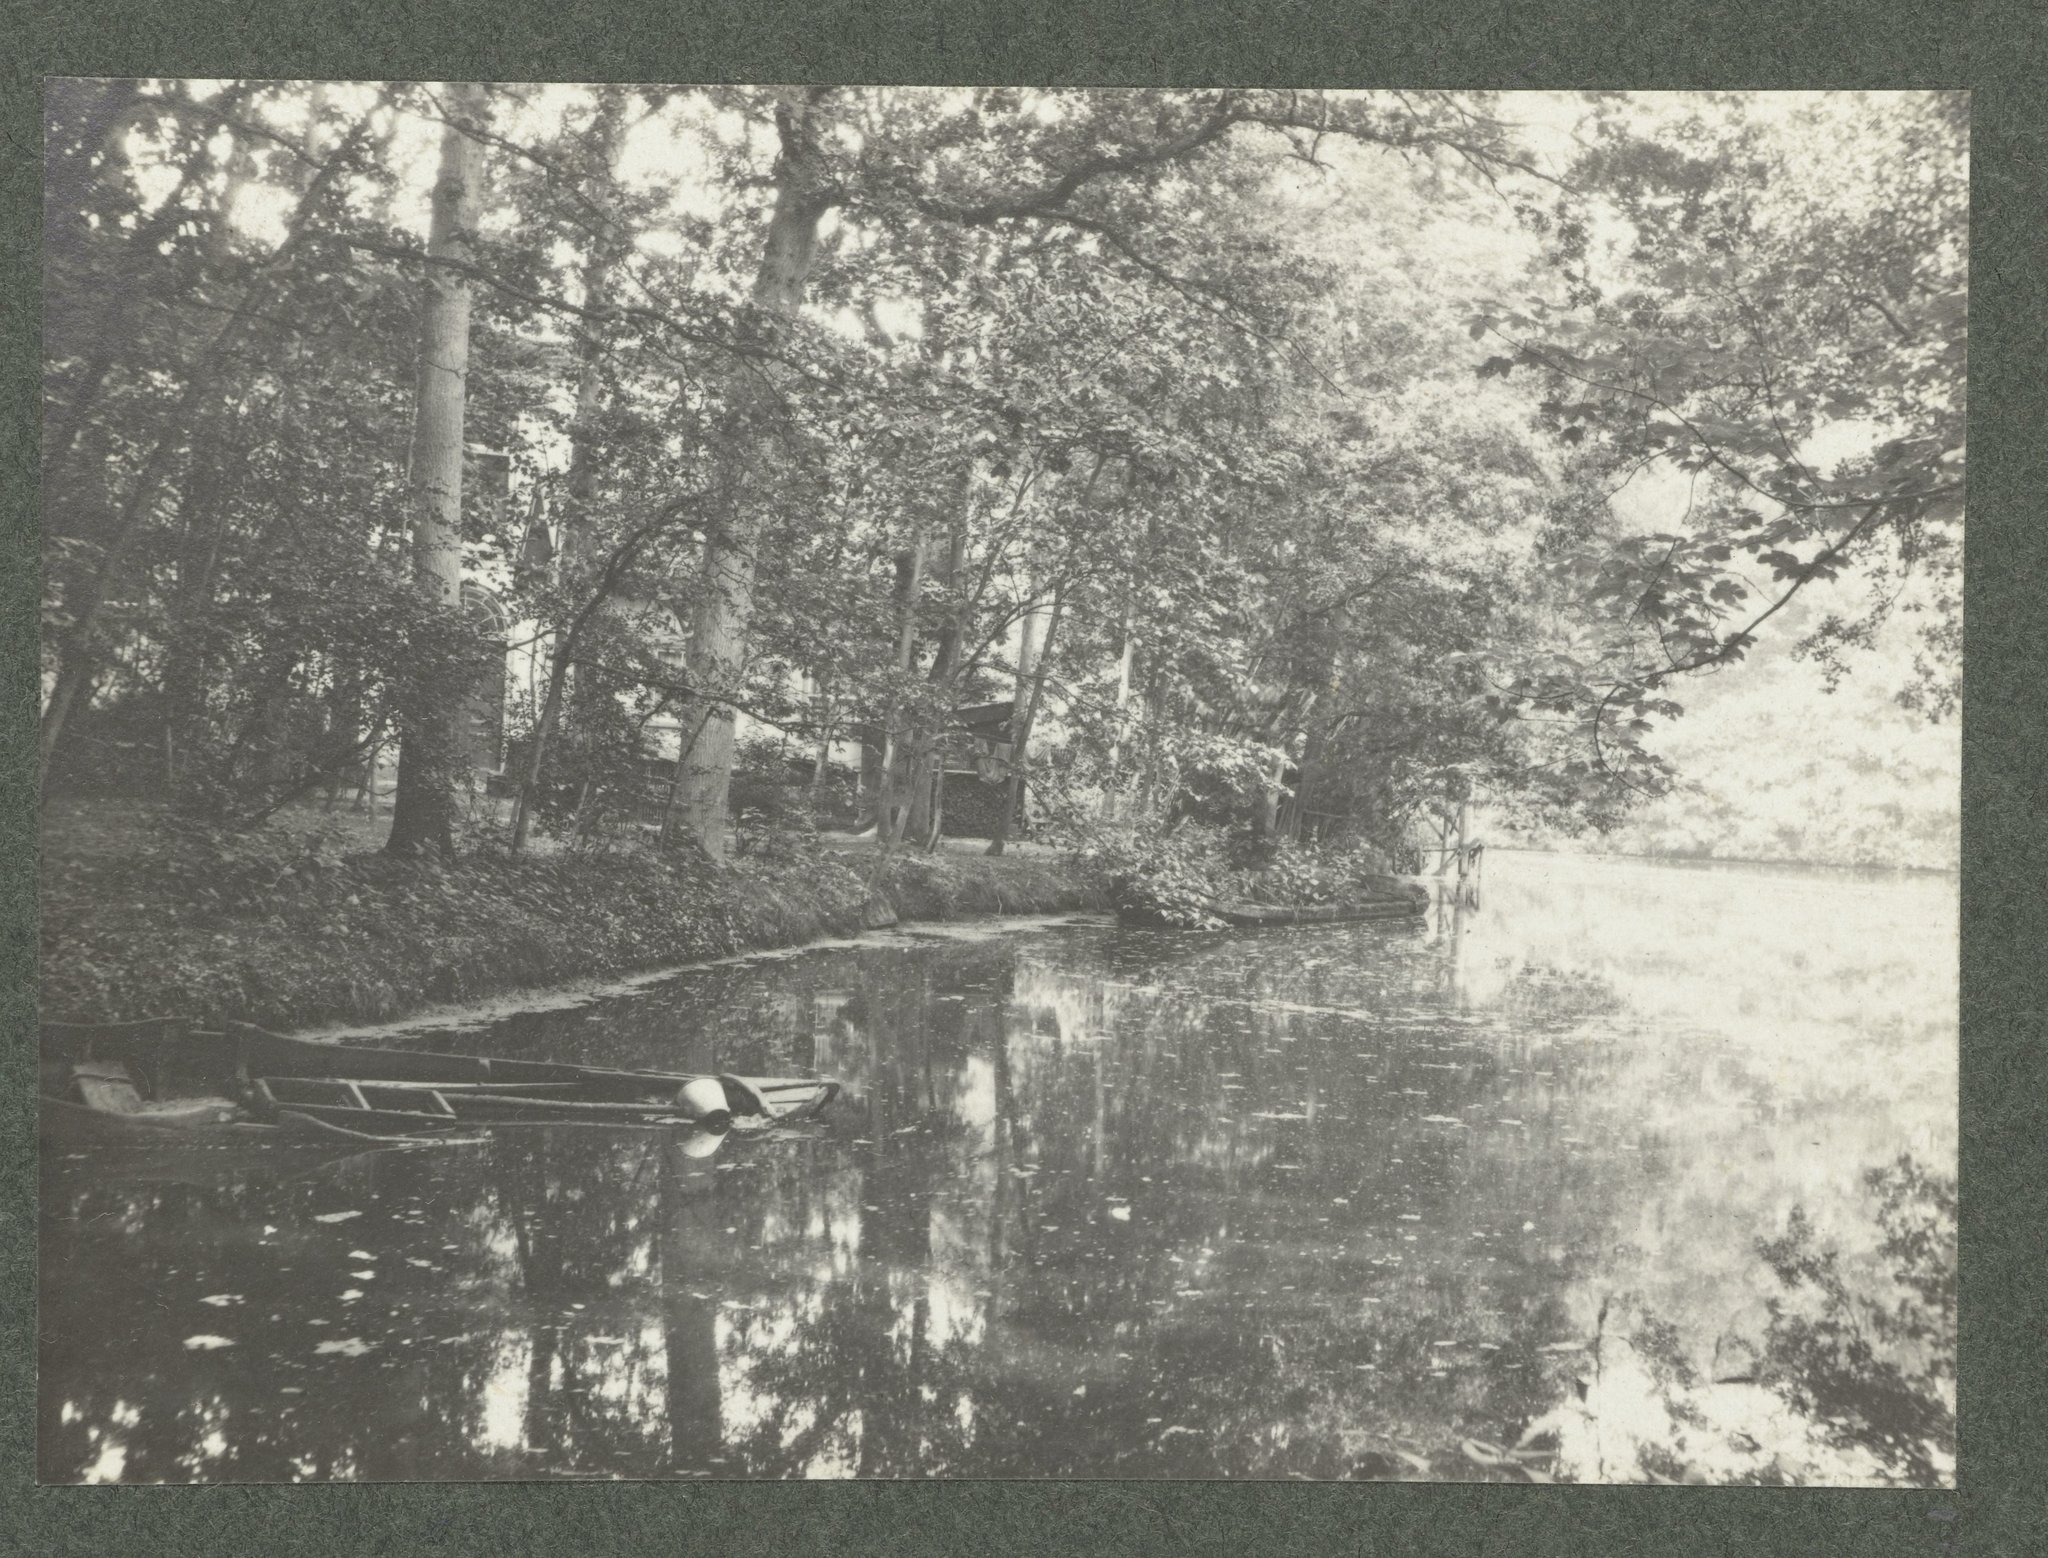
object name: photograph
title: Ondergelopen roeiboot in een dicht beboste omgeving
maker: geldolph adriaan kessler (dolph)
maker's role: fotograaf, industrieel, voetballer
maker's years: 1884-1945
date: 1913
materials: paper, photographic support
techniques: photography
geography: netherlands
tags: huize de paauw